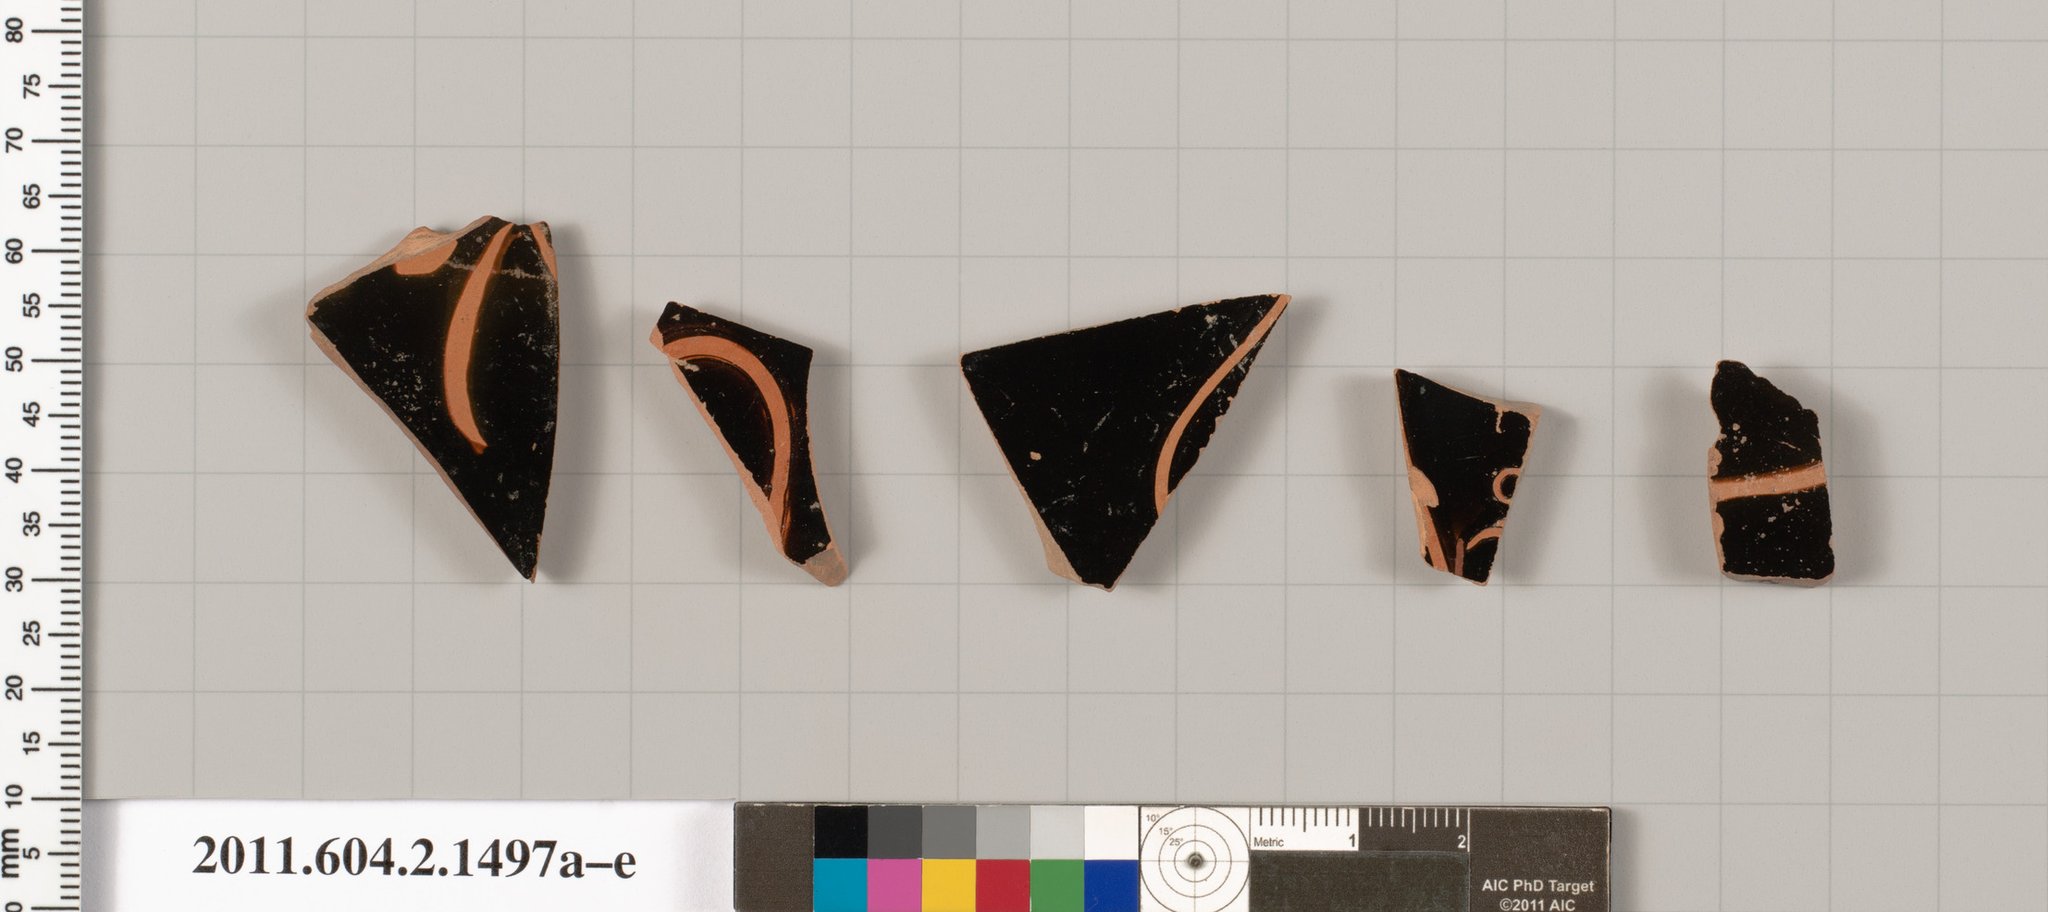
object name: skyphos fragment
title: Terracotta fragments of skyphoi (deep drinking cups)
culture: greek, attic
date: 475-440 BCE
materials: terracotta